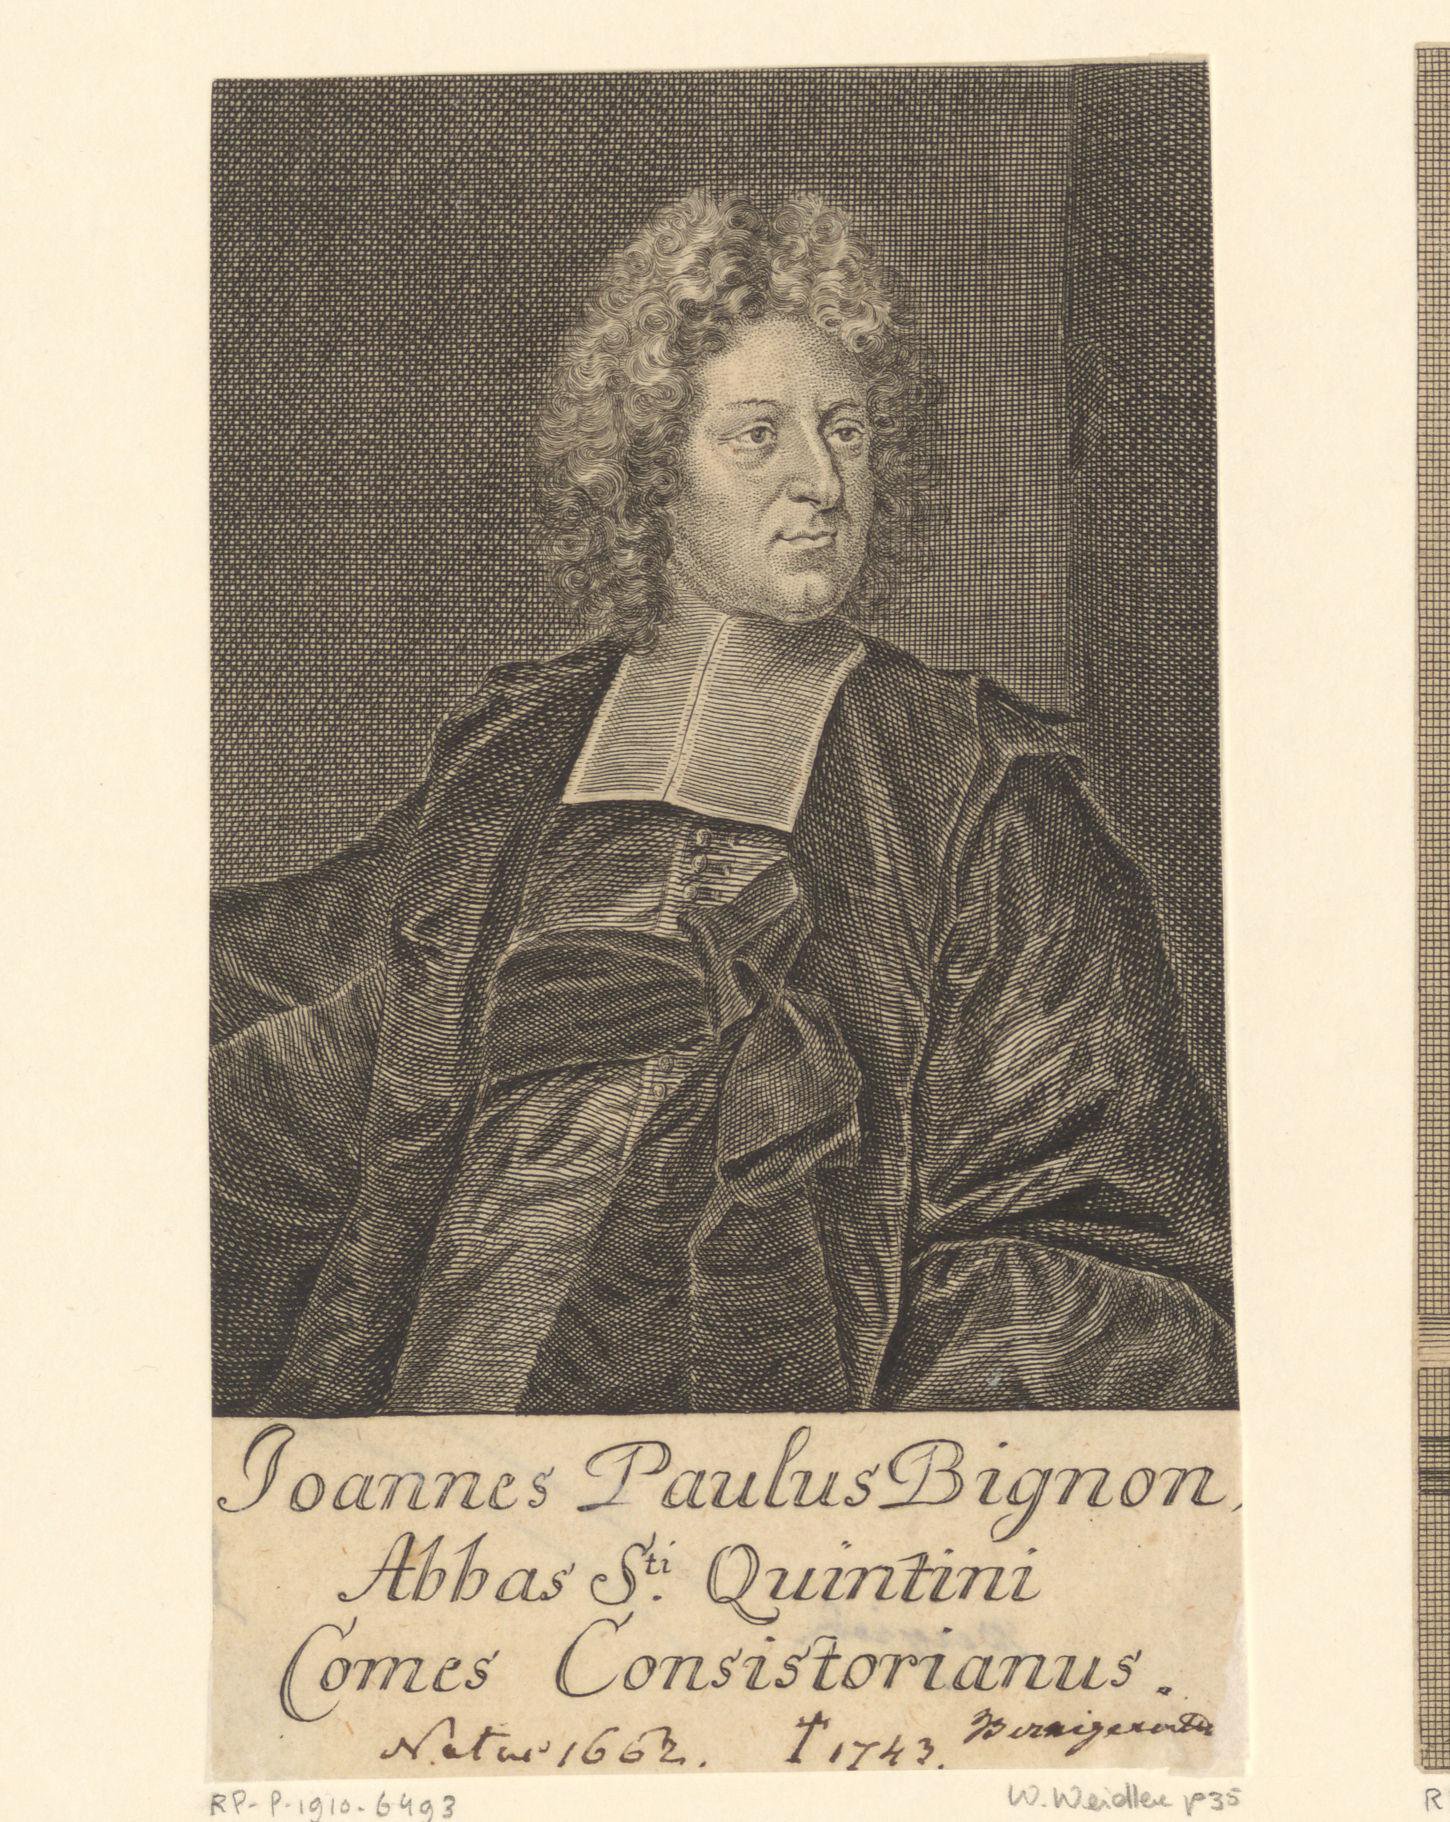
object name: print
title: Portret van Jean Paul Bignon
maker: martin bernigeroth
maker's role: print maker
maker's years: 1670-1733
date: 1713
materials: paper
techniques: engraving, etching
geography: leipzig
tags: jean-paul bignon, historical persons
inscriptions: collector's mark: Lugt 2228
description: Prent ook gebruikt in: Deutsche Acta Eruditorum (...). dl. 18. Leipzig: Johann Gottlieb Gleditsch, 1713.